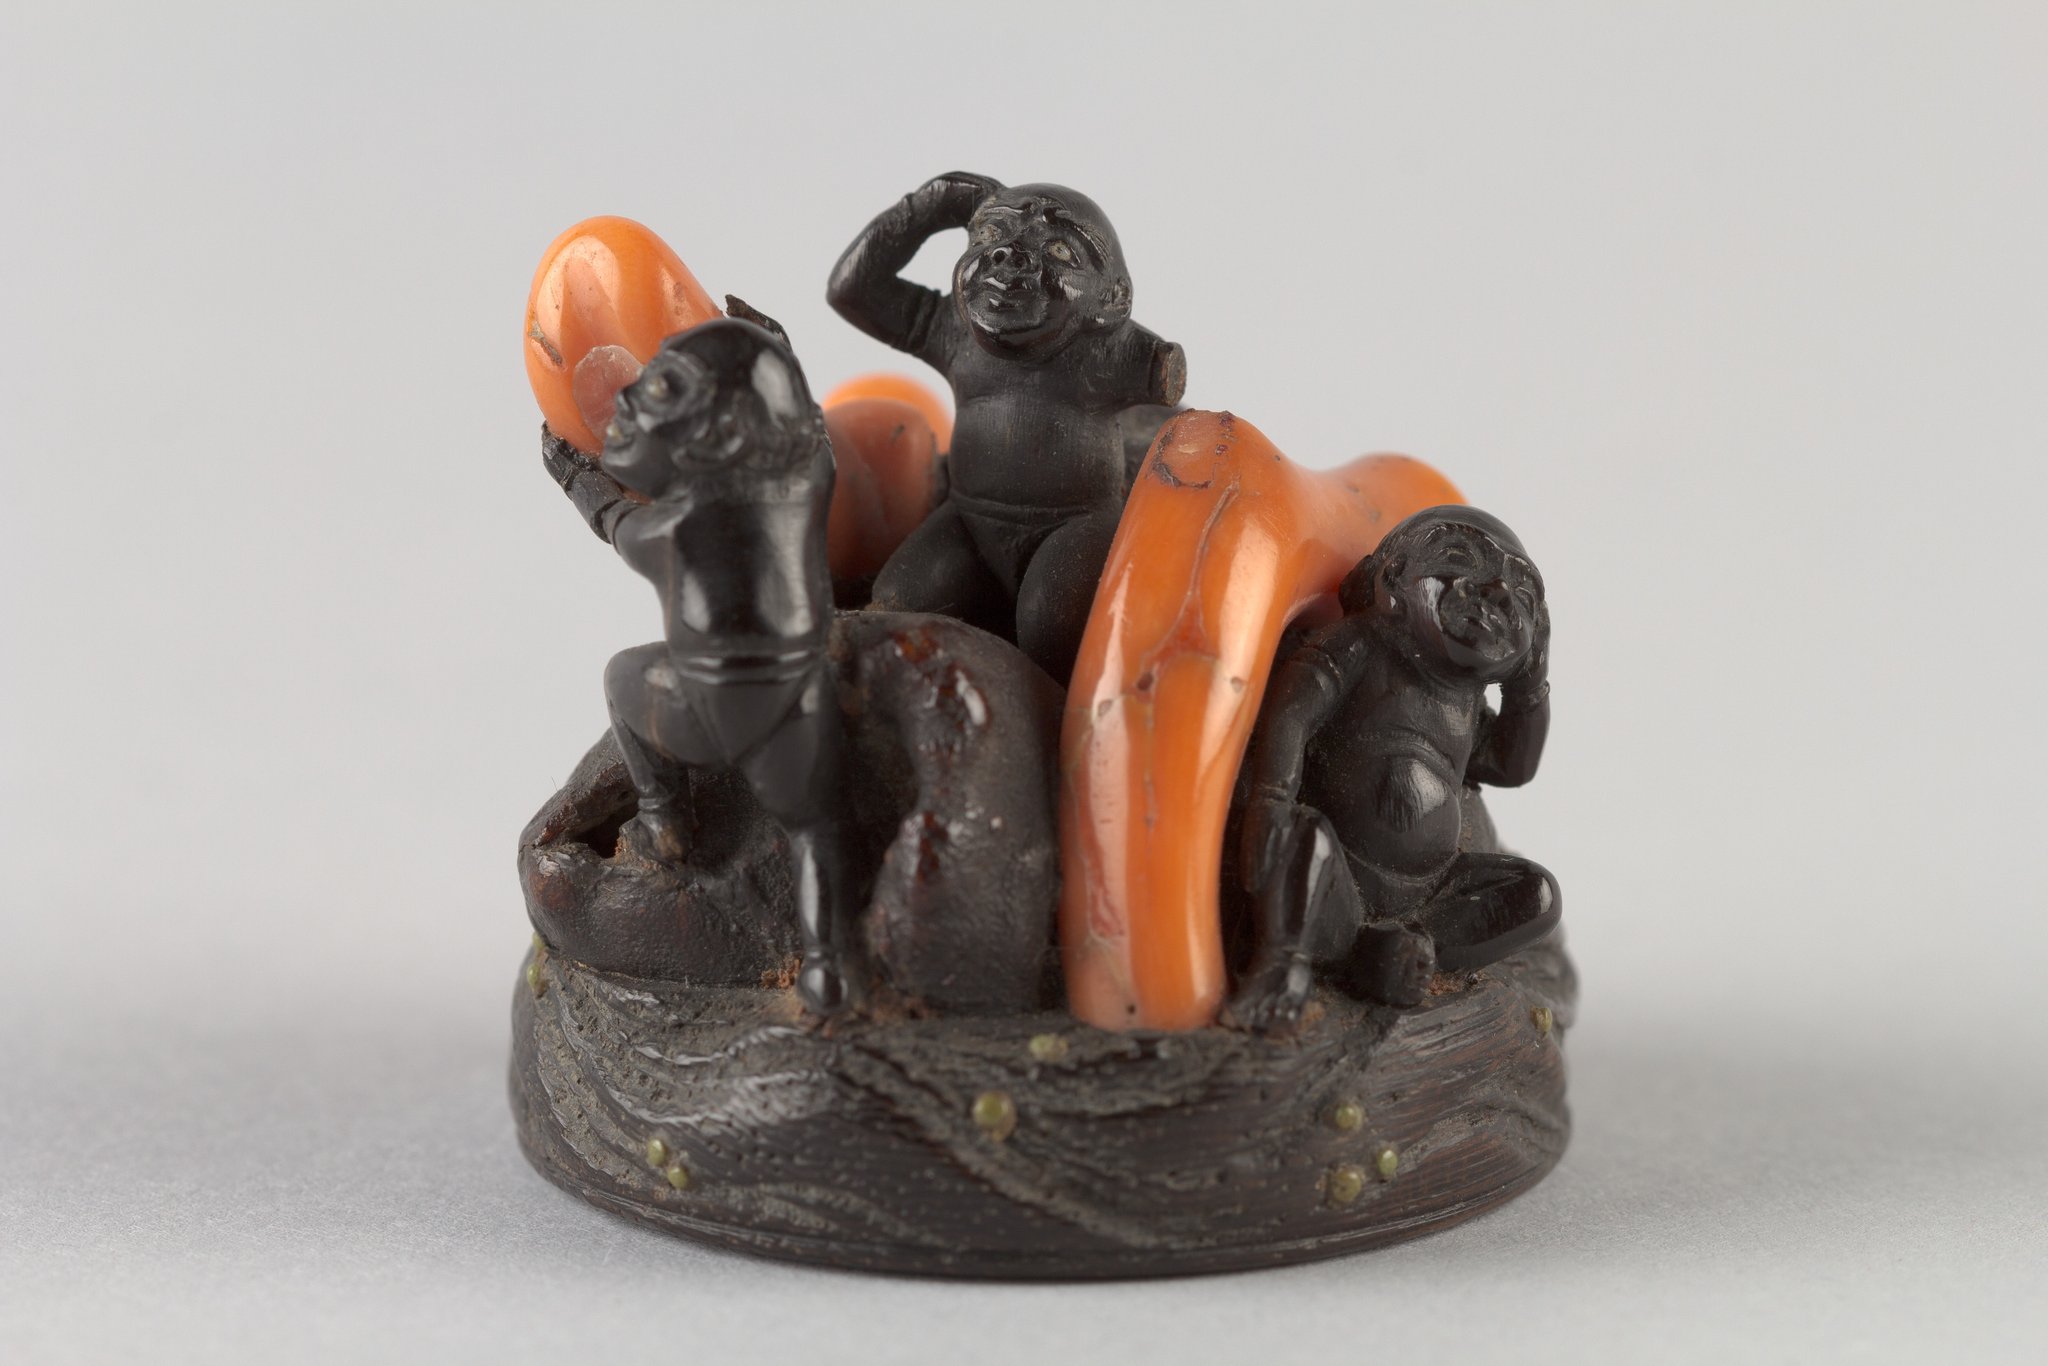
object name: netsuke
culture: japanese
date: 1801-1900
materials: coral, wood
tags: human figures